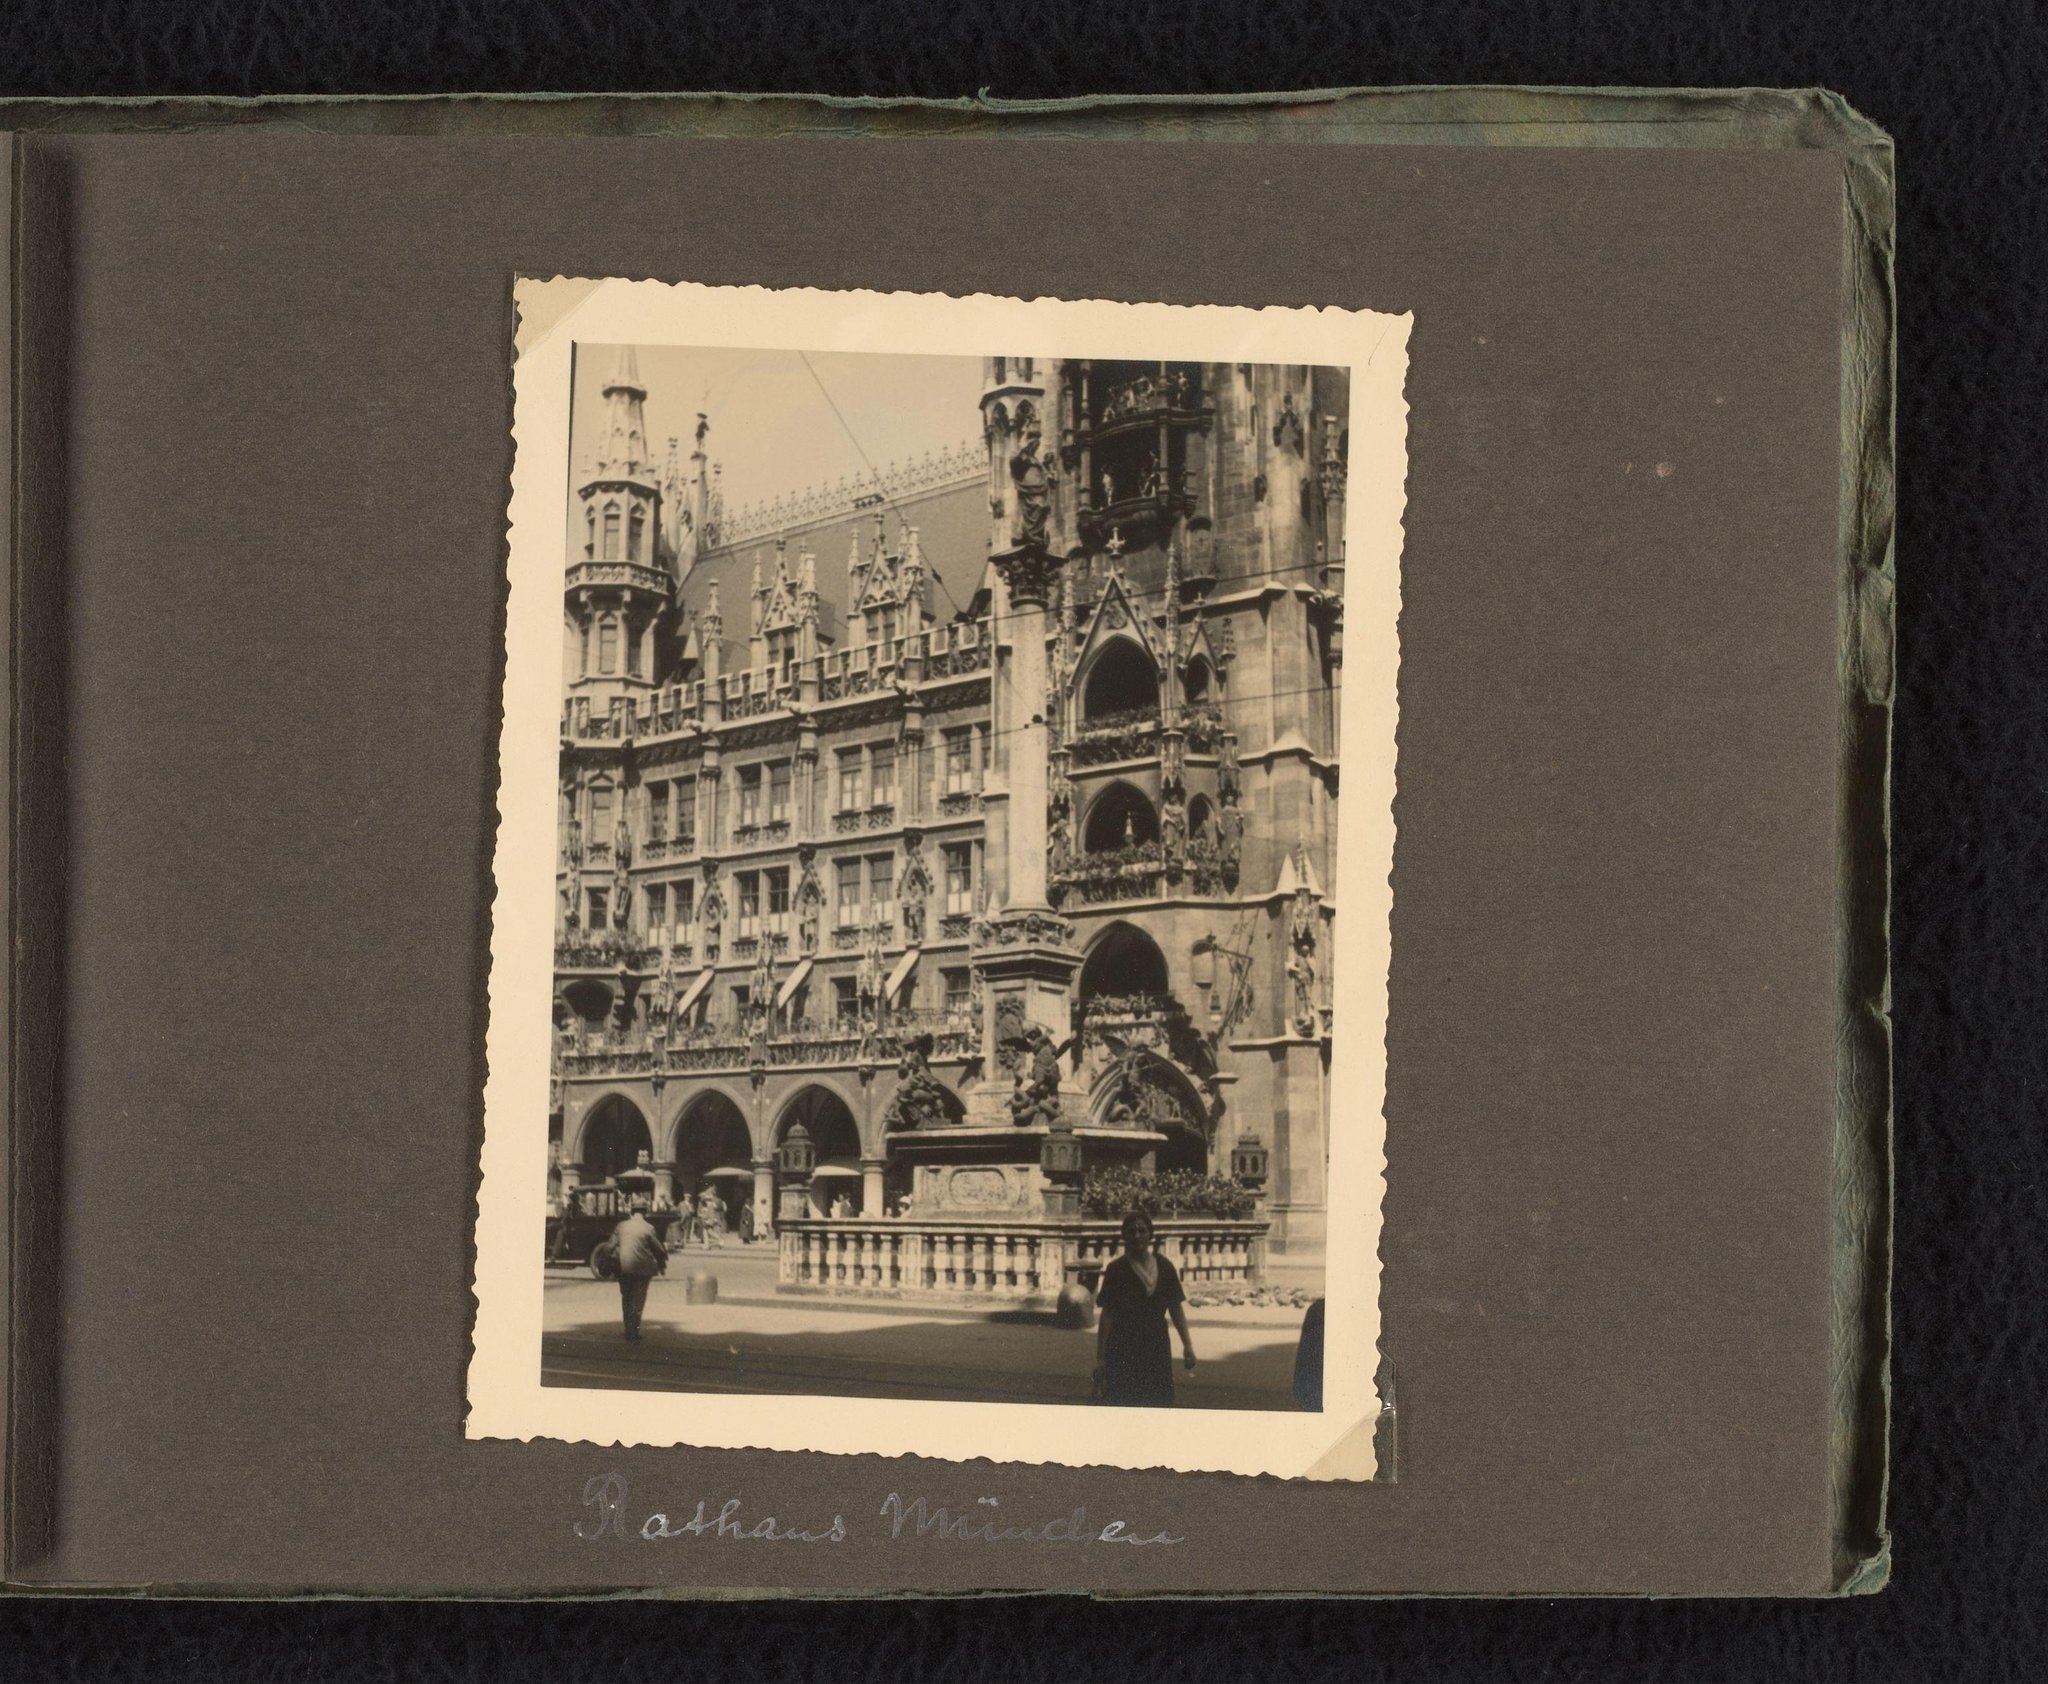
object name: album leaf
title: Raadhuis in München, augustus 1932, München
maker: else wachenheimer-moos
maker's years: 1895-1944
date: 1908-1932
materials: paper, photographic support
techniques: gelatin silver print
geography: munich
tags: the family travelling, on holiday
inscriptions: inscription: ‘Rathaus München’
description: Blad bevat een foto met onbekende personen. Uit het album, half formaat, groen geaderd kartonomslag met koordbinding.